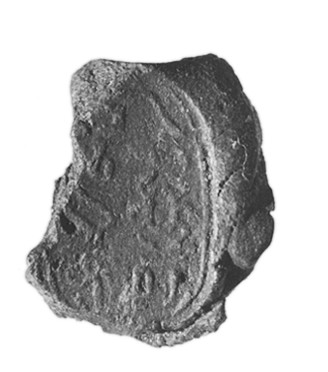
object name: sealing fragment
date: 2030-1640 BCE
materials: clay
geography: egypt